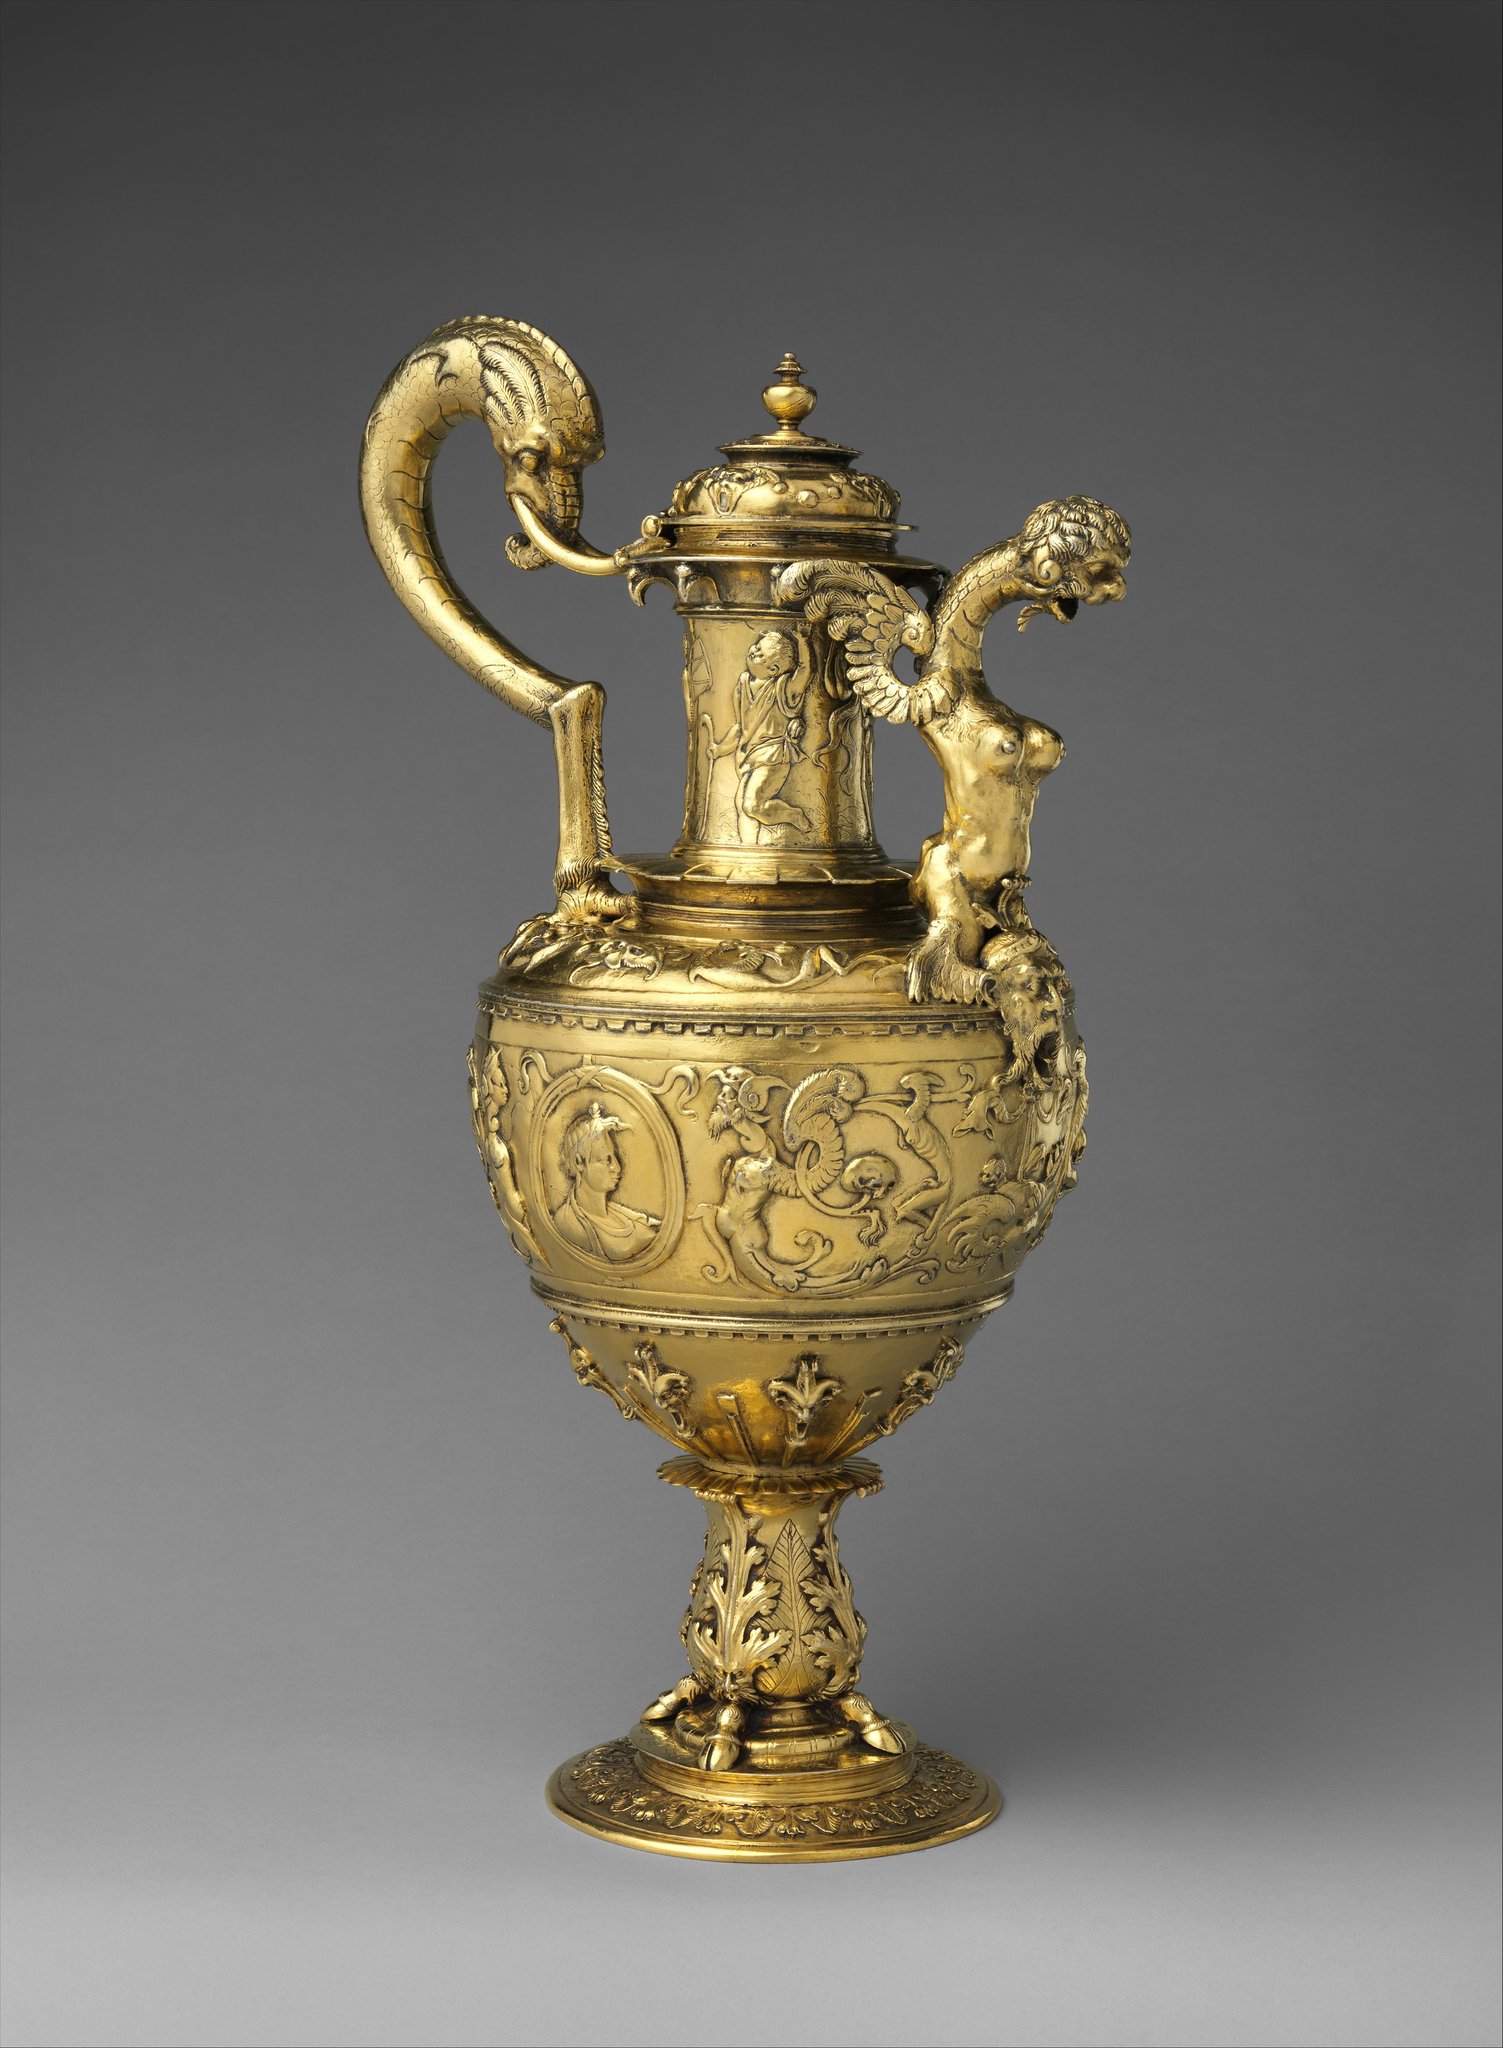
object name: ewer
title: Ceremonial ewer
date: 1520-1550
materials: gilt, silver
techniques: chasing, embossing, engraving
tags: mythical creatures